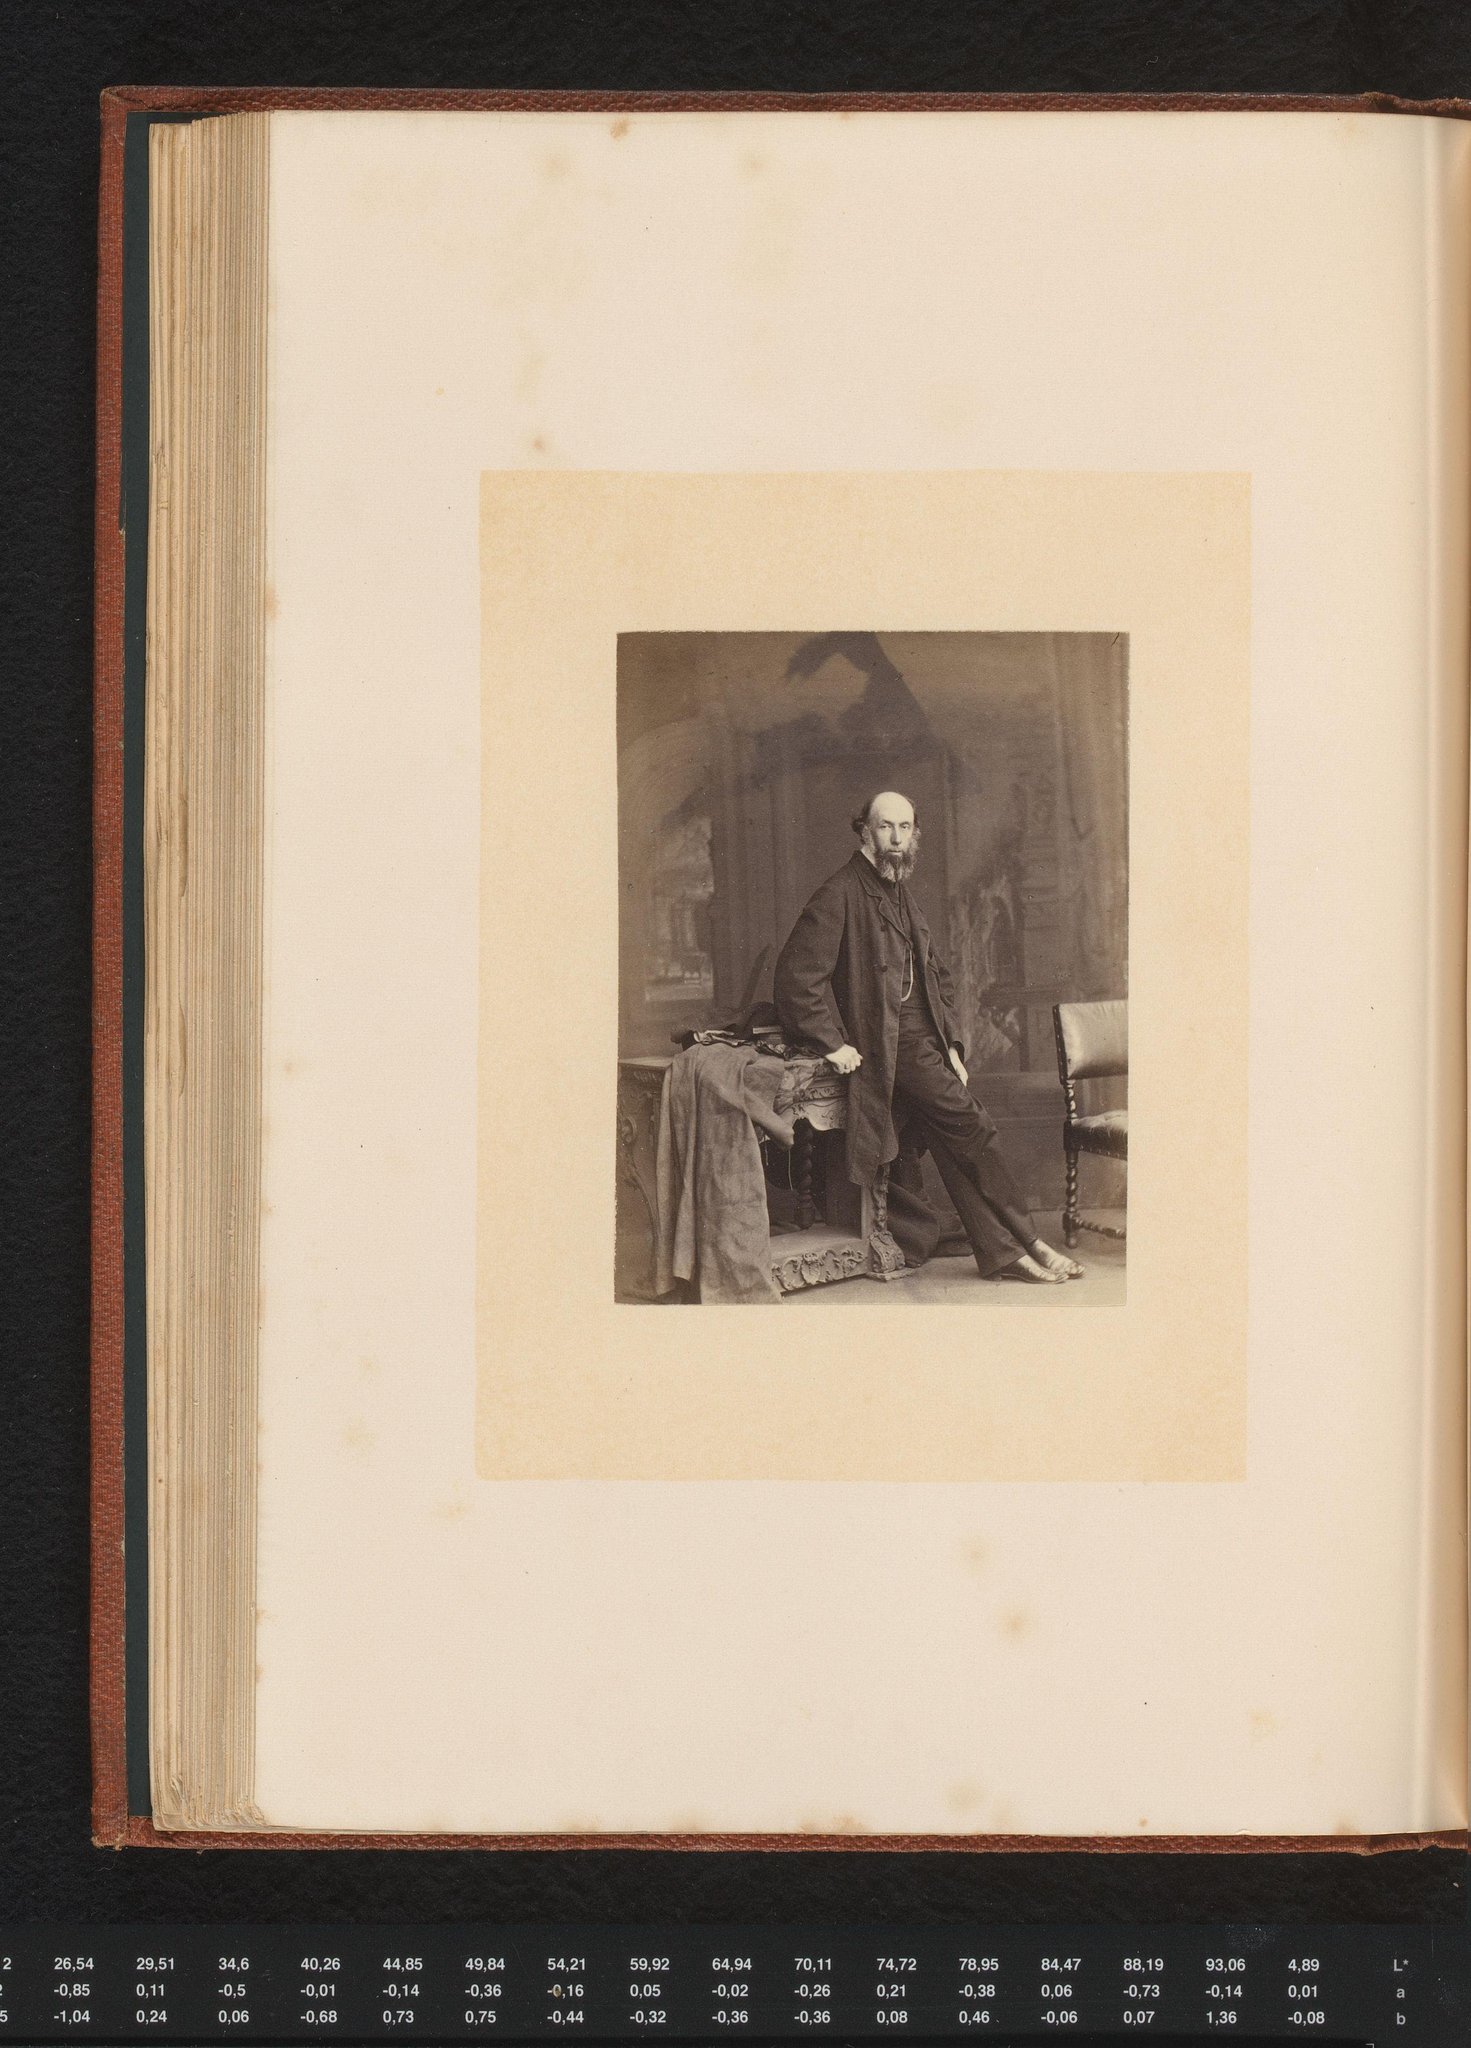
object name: photograph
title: Portret van de schilder Frederick Richard Pickersgill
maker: ernest edwards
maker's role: fotograaf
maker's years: 1837-1903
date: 1861-1866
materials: paper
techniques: albumen print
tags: portrait, self-portrait of painter